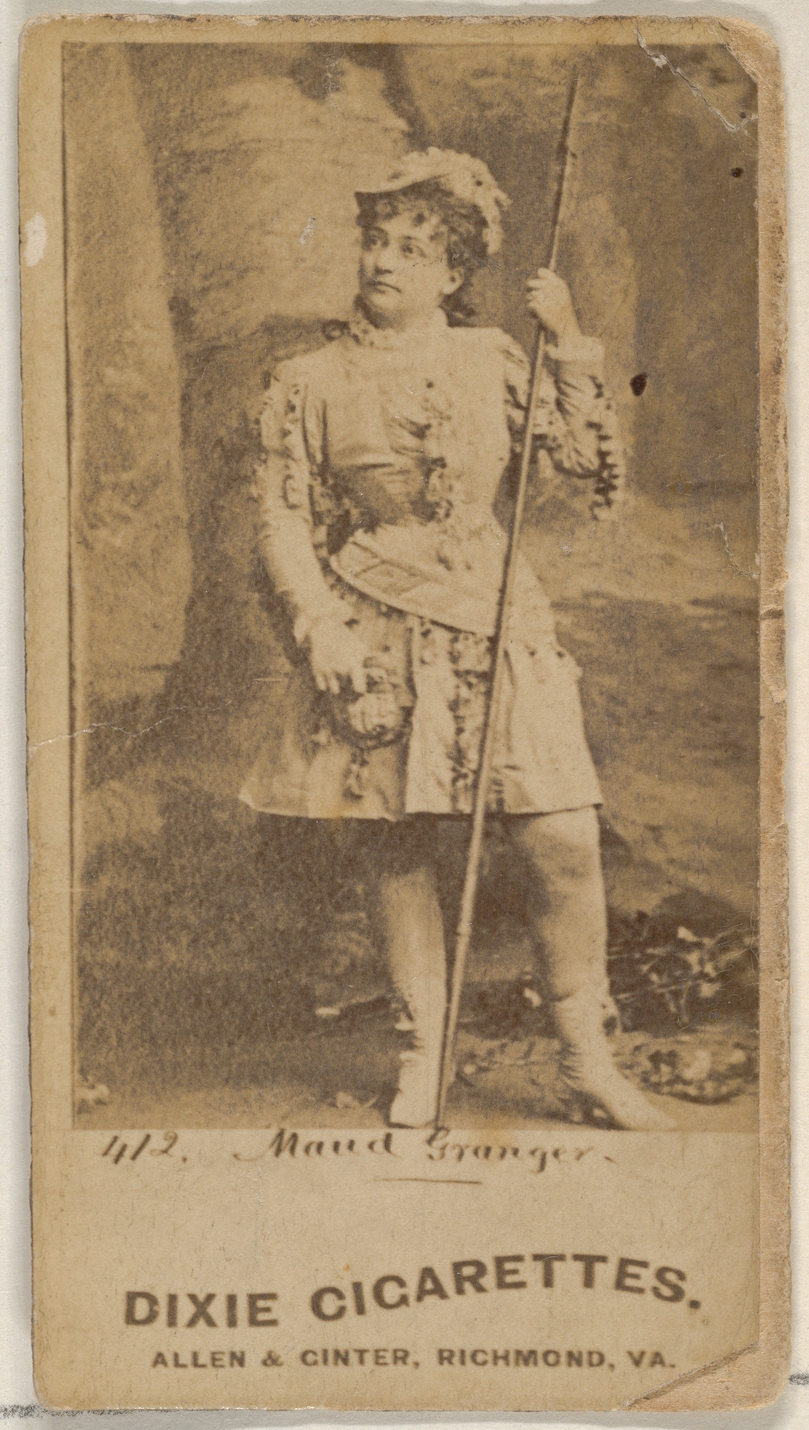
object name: photograph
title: Card 412, Maud Granger, from the Actors and Actresses series (N45, Type 7) for Dixie Cigarettes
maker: allen & ginter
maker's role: publisher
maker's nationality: american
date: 1888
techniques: albumen silver print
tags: portraits,women,actresses